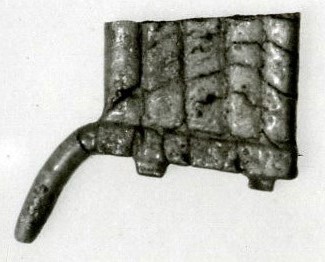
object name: inlay, hieroglyph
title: Inlay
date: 664-610 BCE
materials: faience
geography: egypt